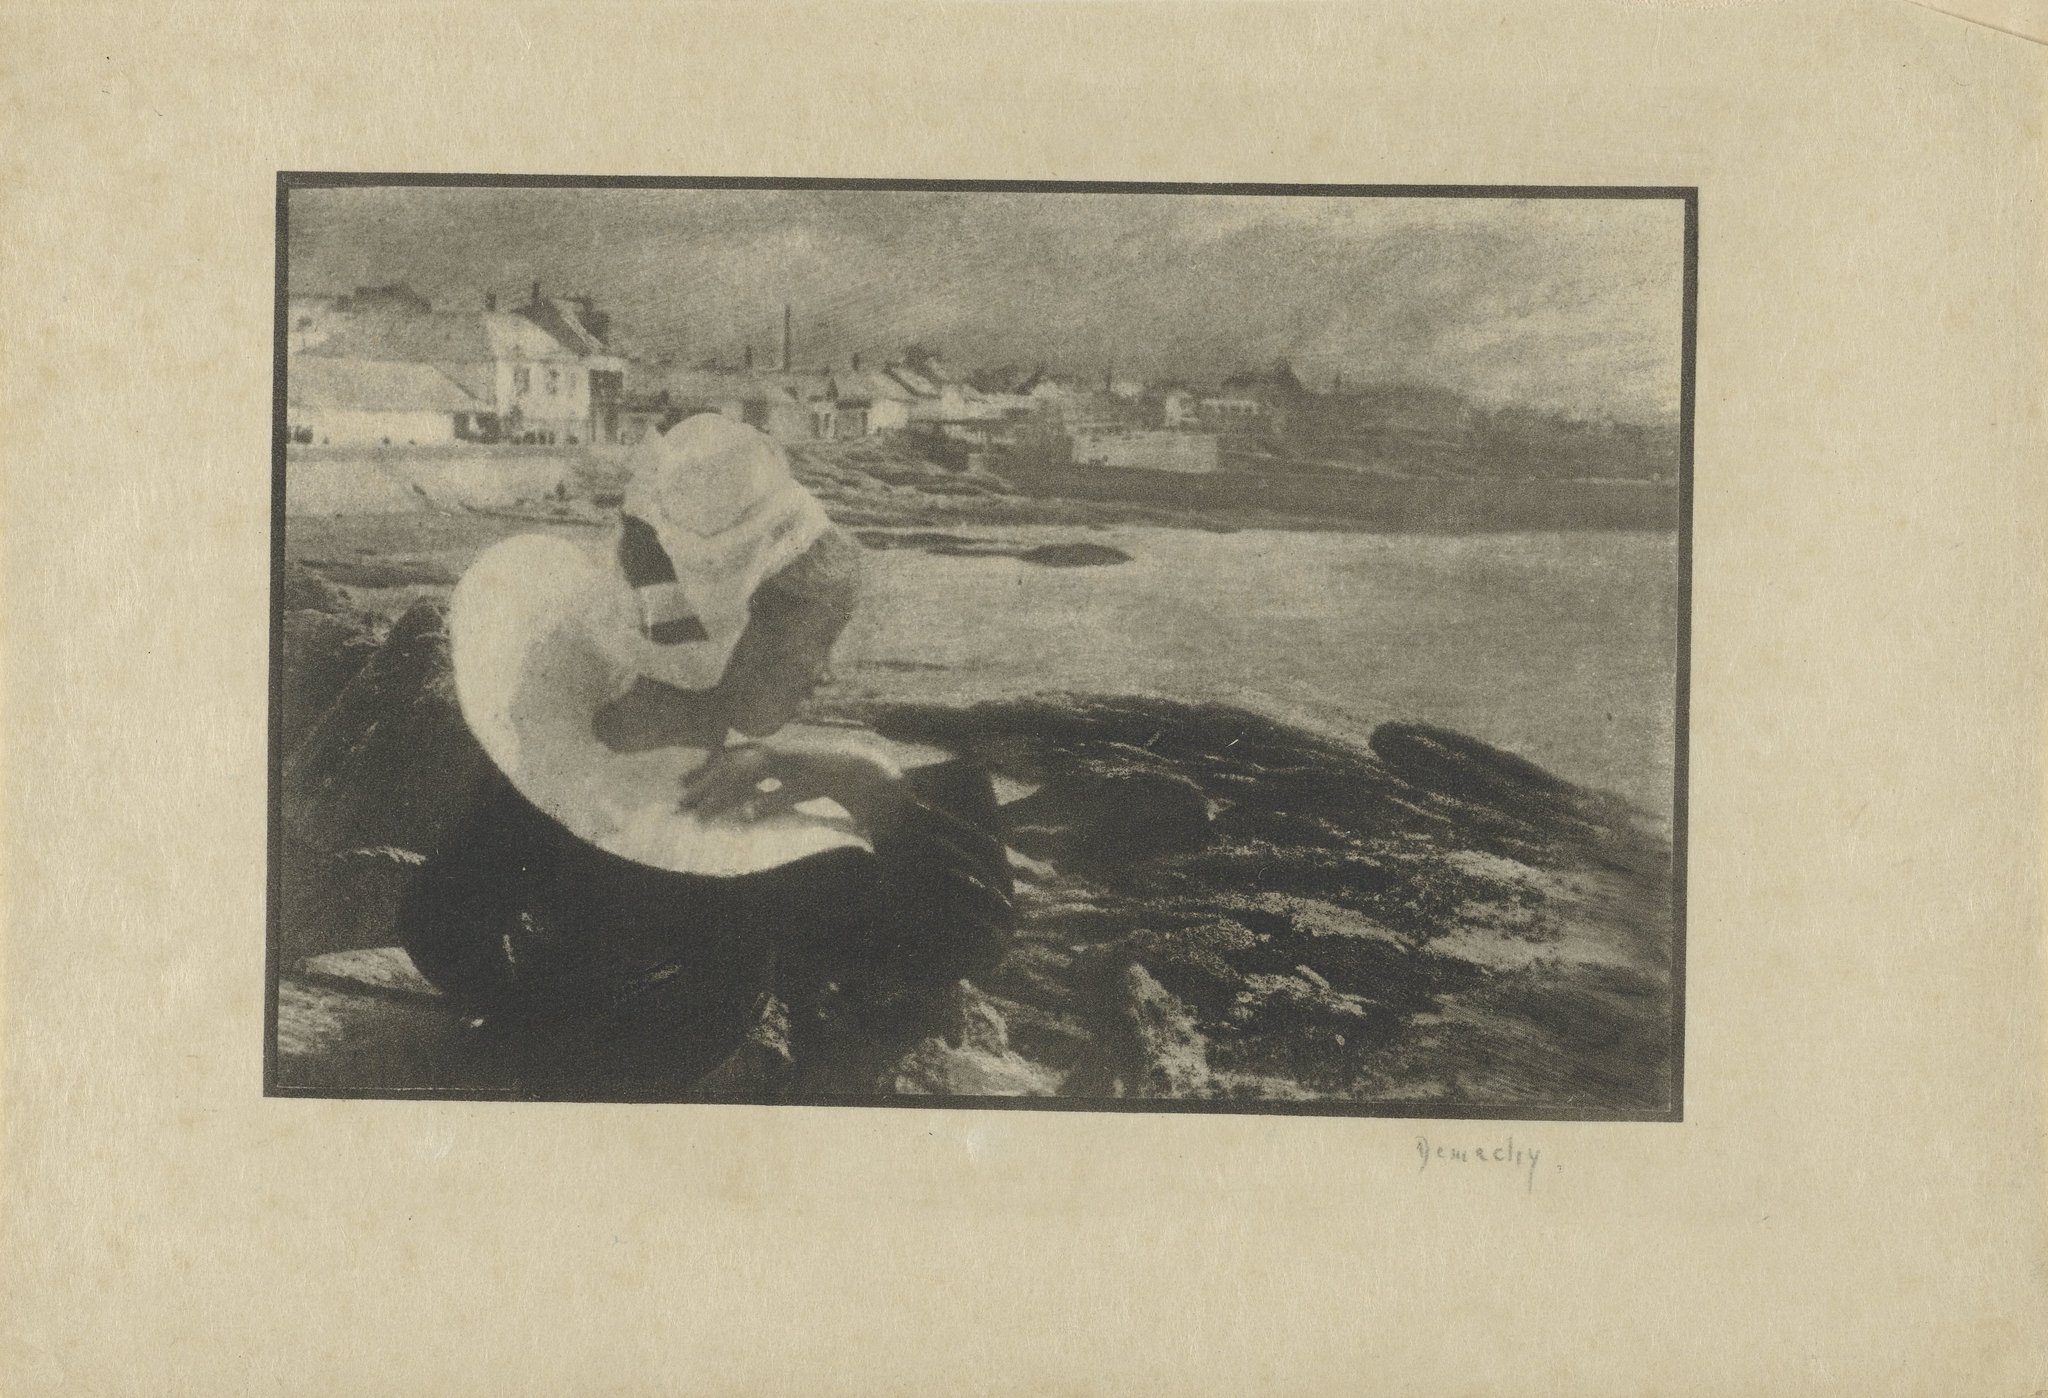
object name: photomechanical print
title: In Brittany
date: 1904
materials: paper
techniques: photoaquatint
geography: brittany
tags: girl (child between toddler and youth), folk costume, regional costume, coast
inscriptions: signature: ‘Demachy’